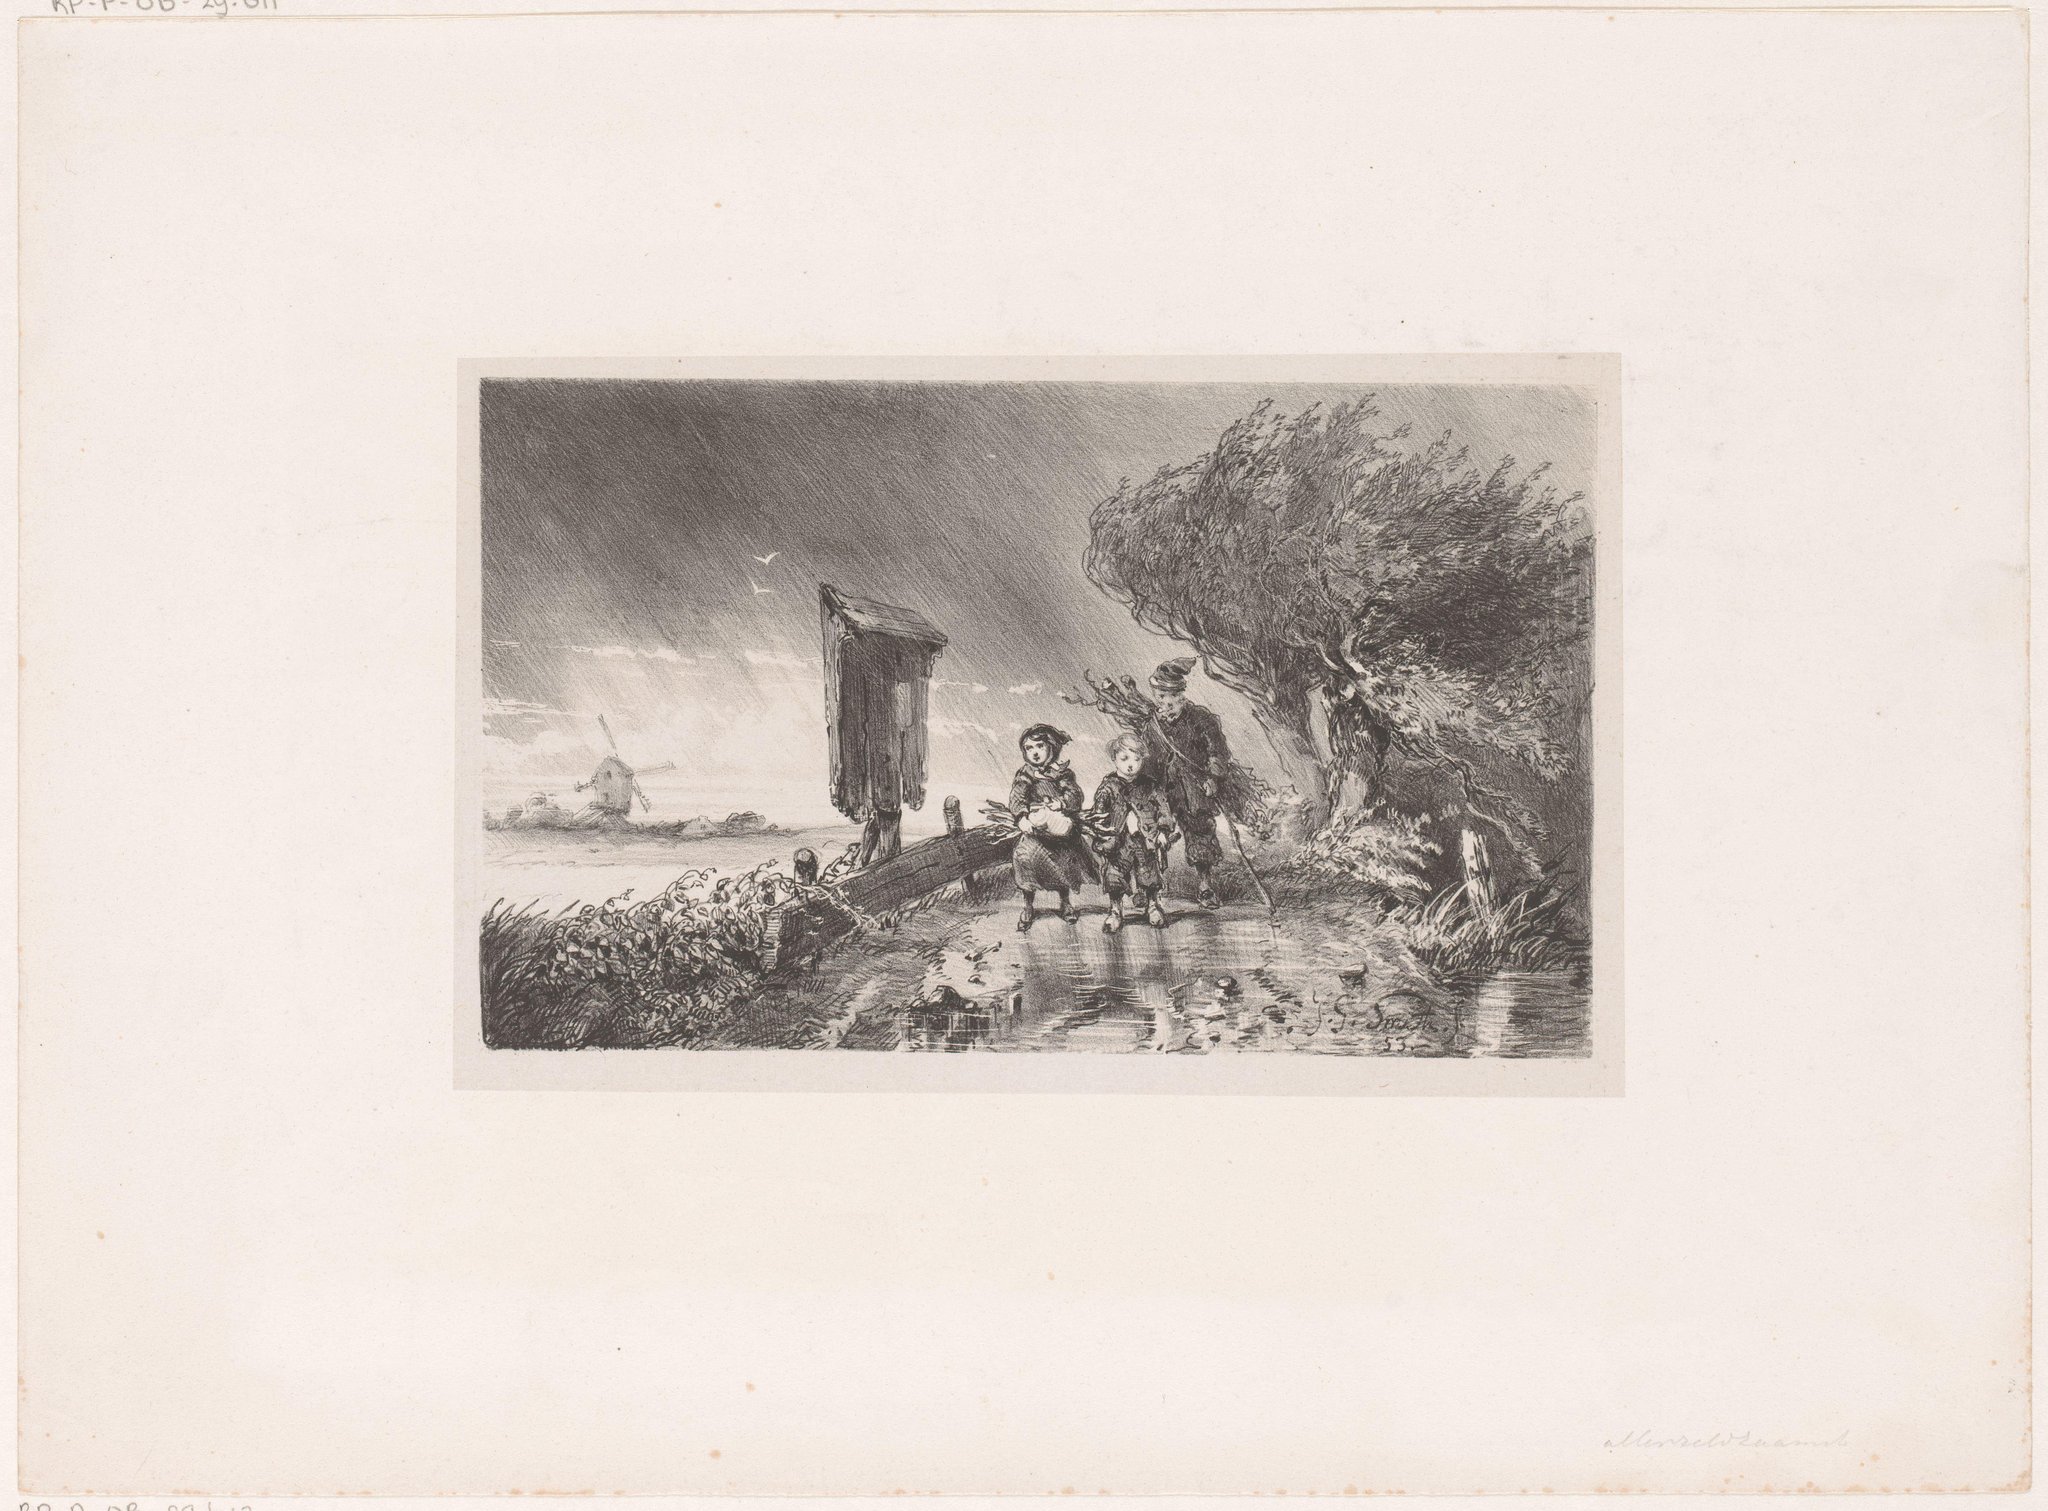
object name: print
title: Houtsprokkelende man en kinderen in de storm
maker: jan gerard smits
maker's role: draughtsman, print maker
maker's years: 1823-1910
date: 1853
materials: paper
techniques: lithograph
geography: the hague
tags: woodgathering, woodgatherer, storm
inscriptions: collector's mark: Lugt 2228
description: Een houtsprokkelende man en twee kinderen lopen in stormachtig weer op een pad. Links in de achtergrond een molen.